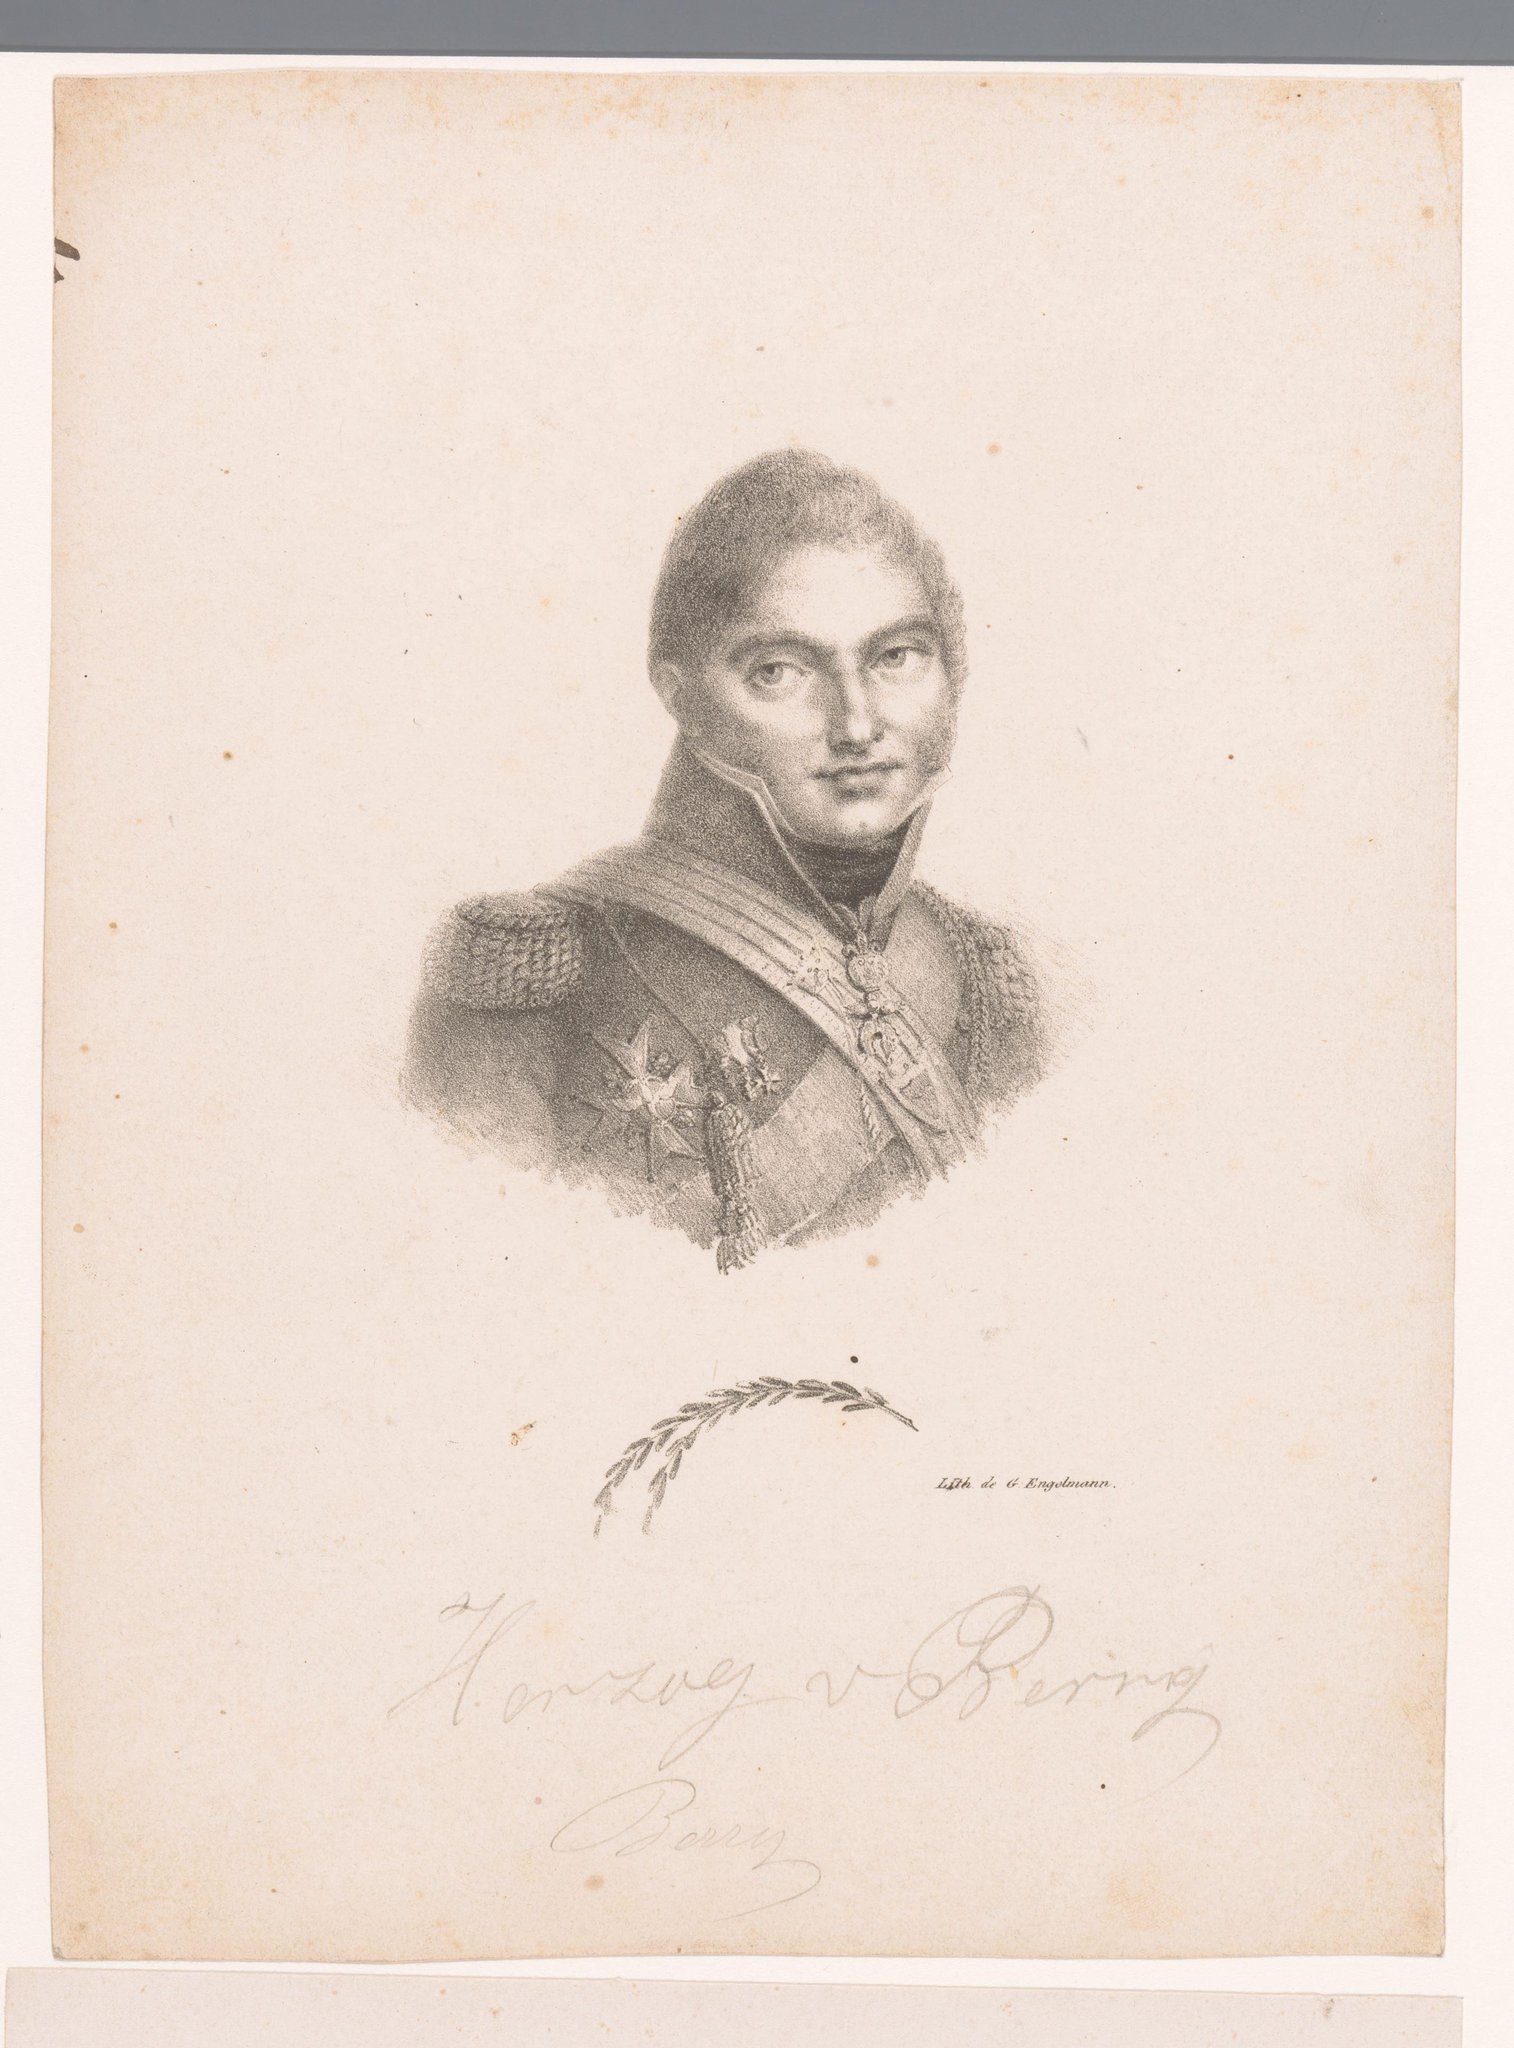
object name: print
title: Portret van Karel Ferdinand van Berry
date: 1816-1839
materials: paper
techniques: lithograph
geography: paris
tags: paris, historical persons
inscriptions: collector's mark: Lugt 2228a